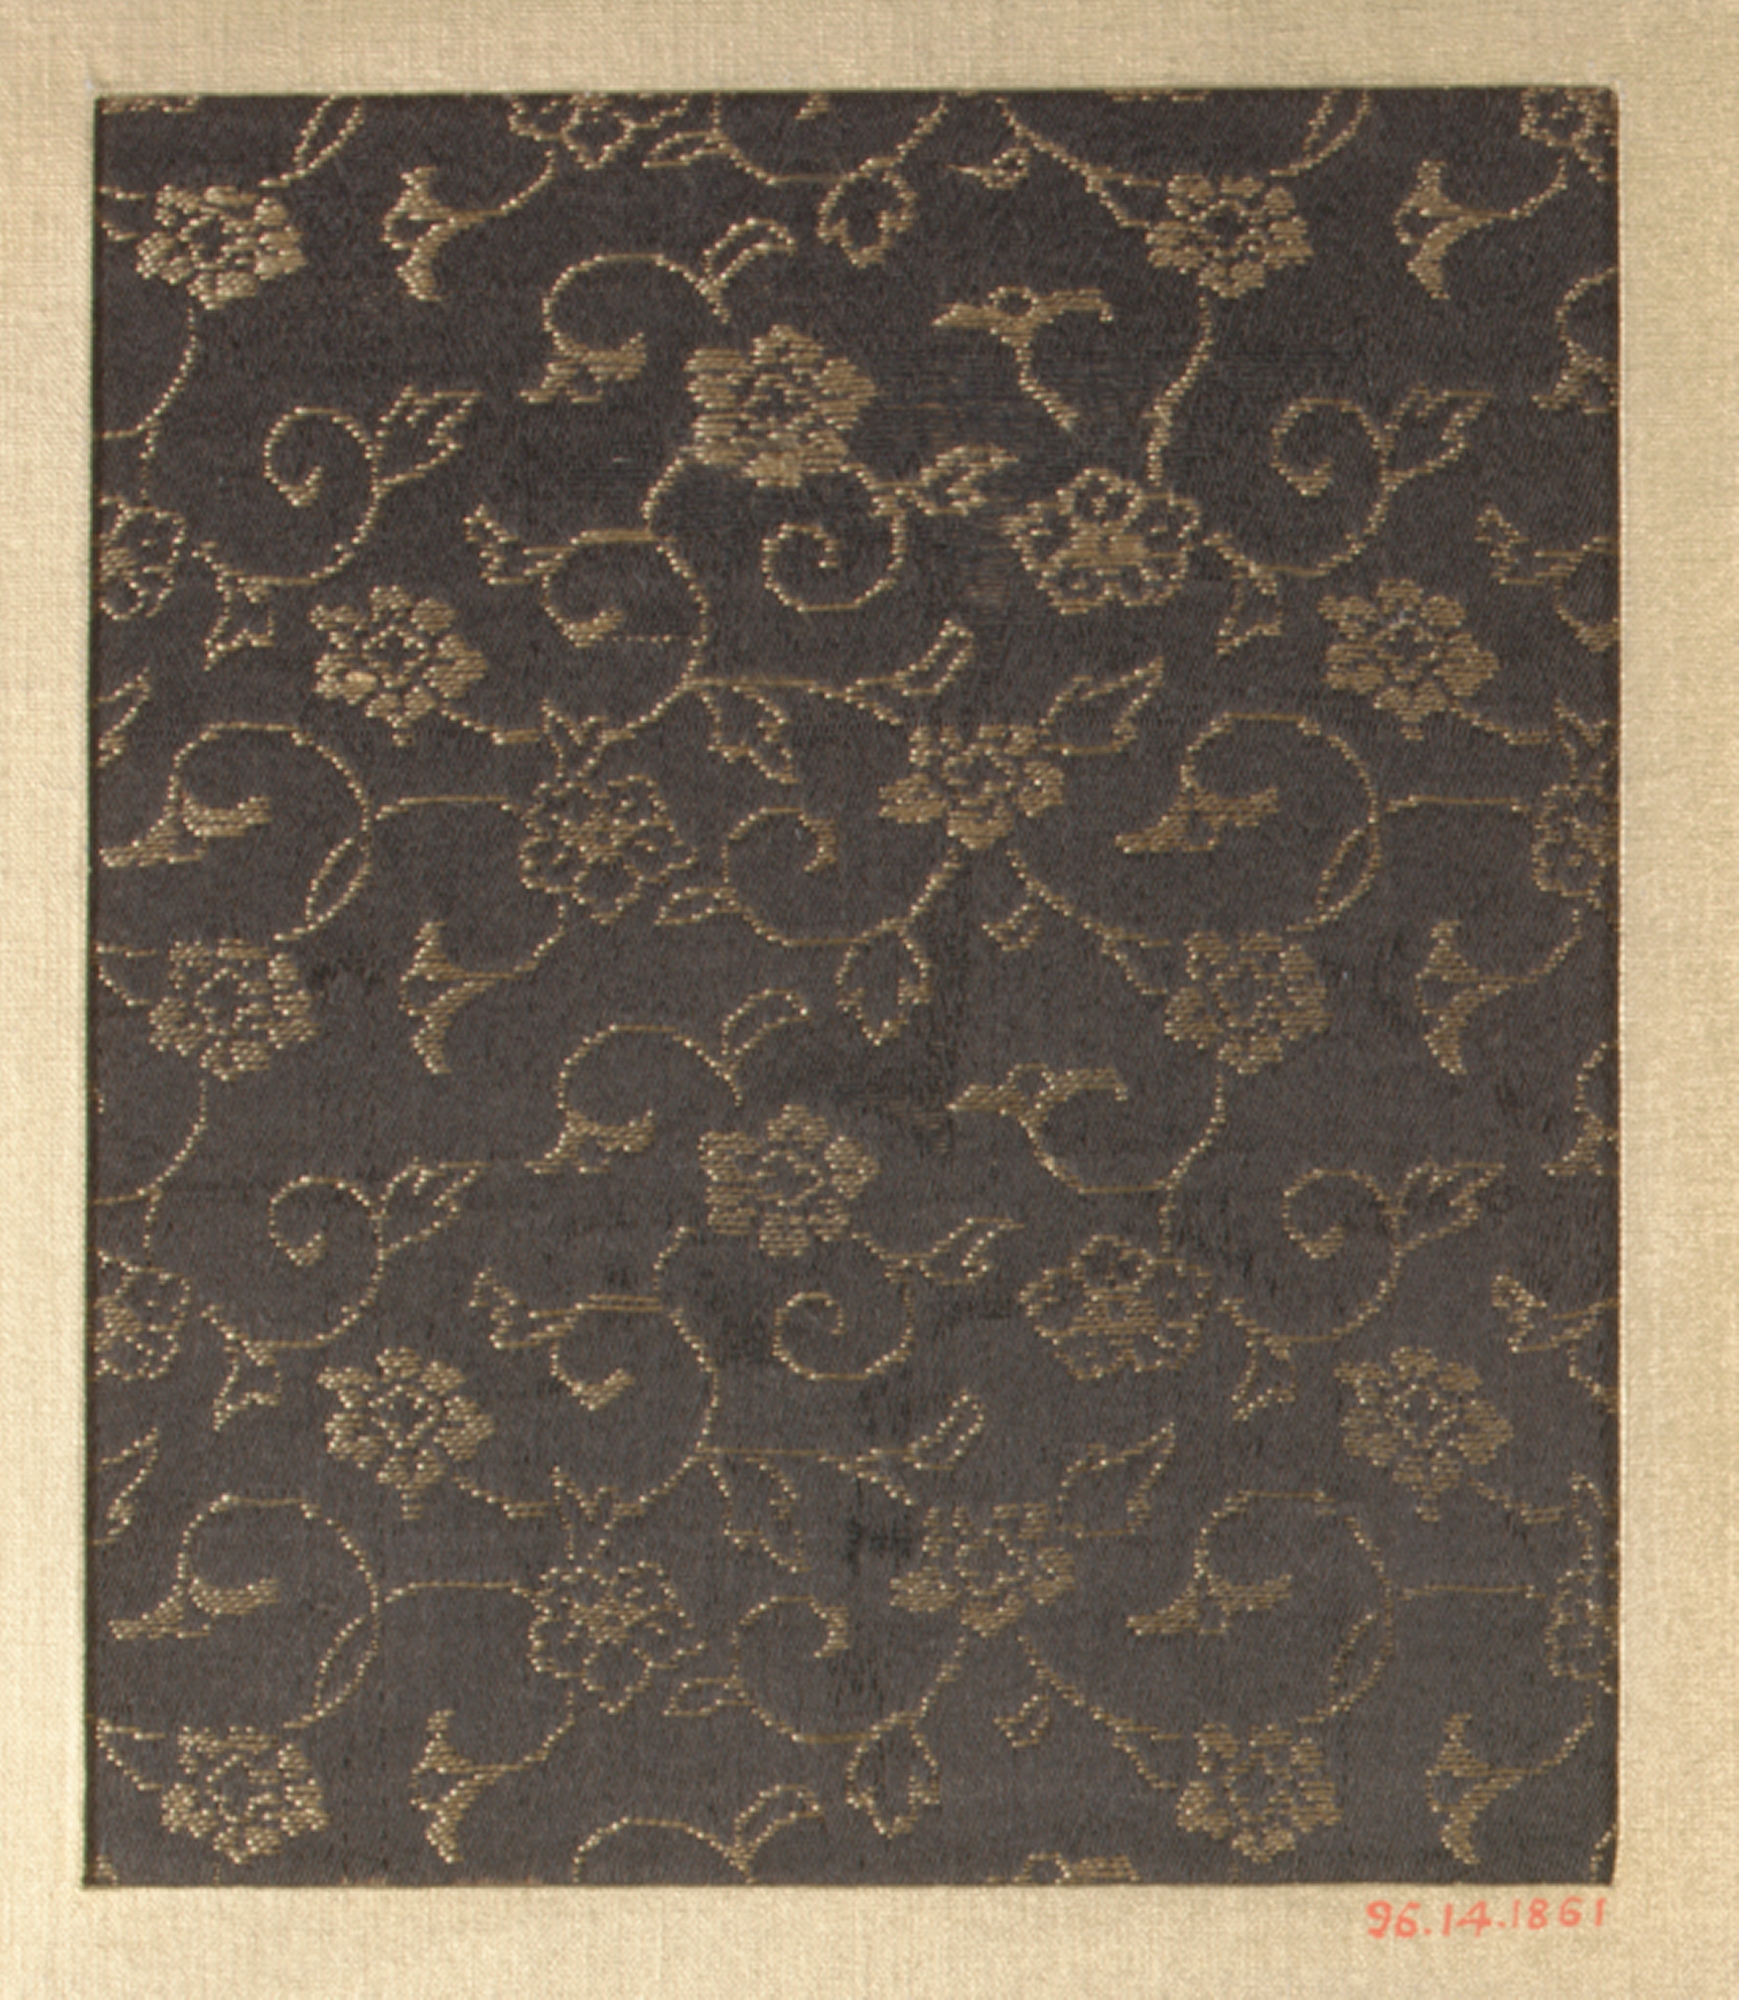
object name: piece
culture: japanese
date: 1701-1900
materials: silk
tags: flowers